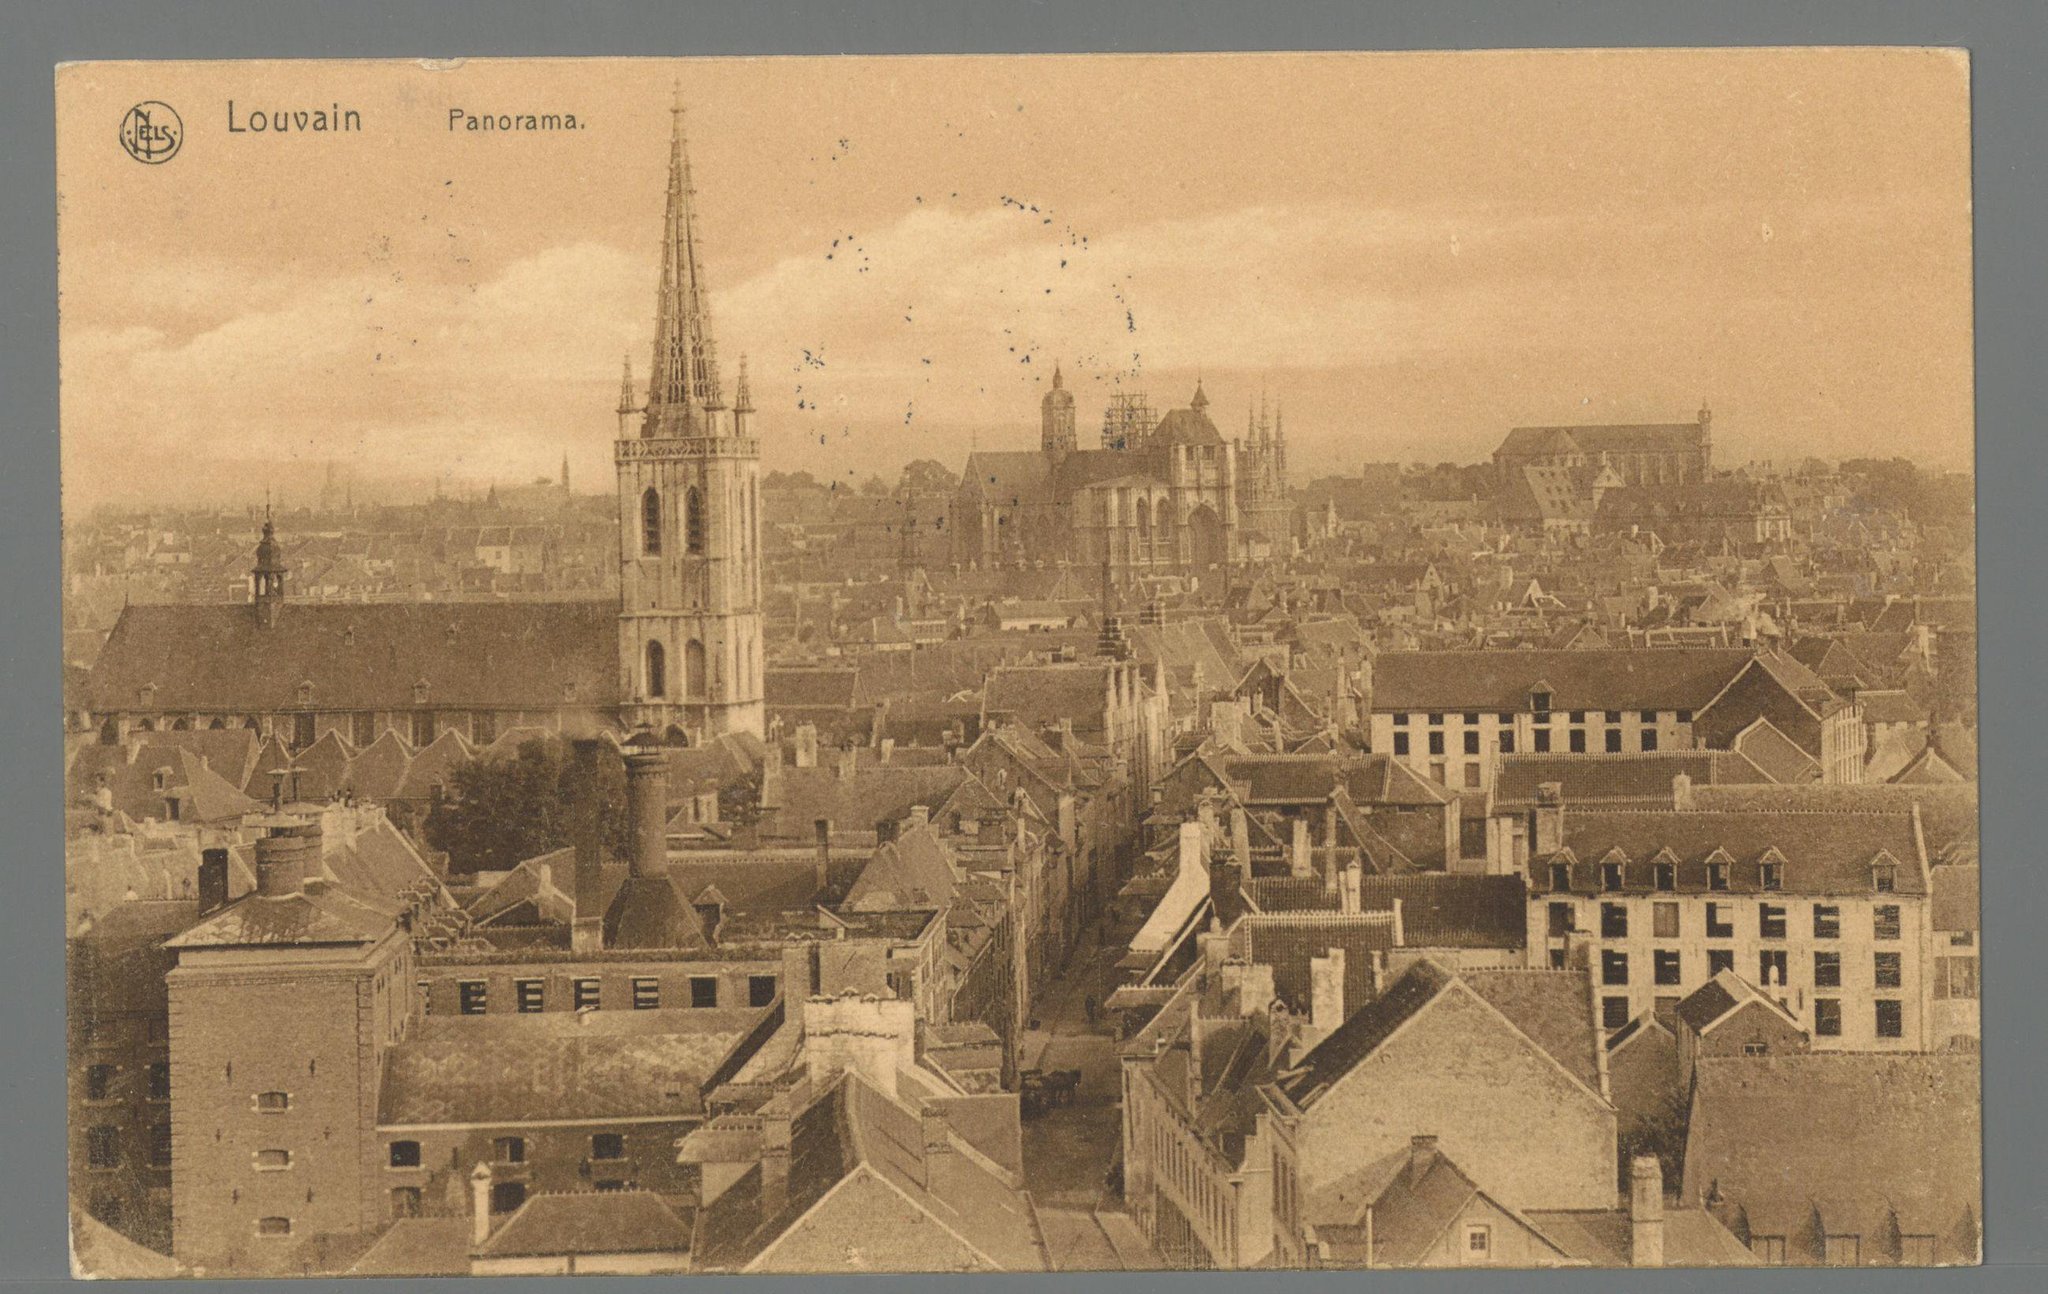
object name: photomechanical print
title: Louvain. Panorama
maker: Anonymous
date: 1907-1909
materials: cardboard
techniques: photograph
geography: leuven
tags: church (exterior), prospect of city, town panorama, silhouette of city, louvain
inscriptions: poststempel, verso, gestempeld